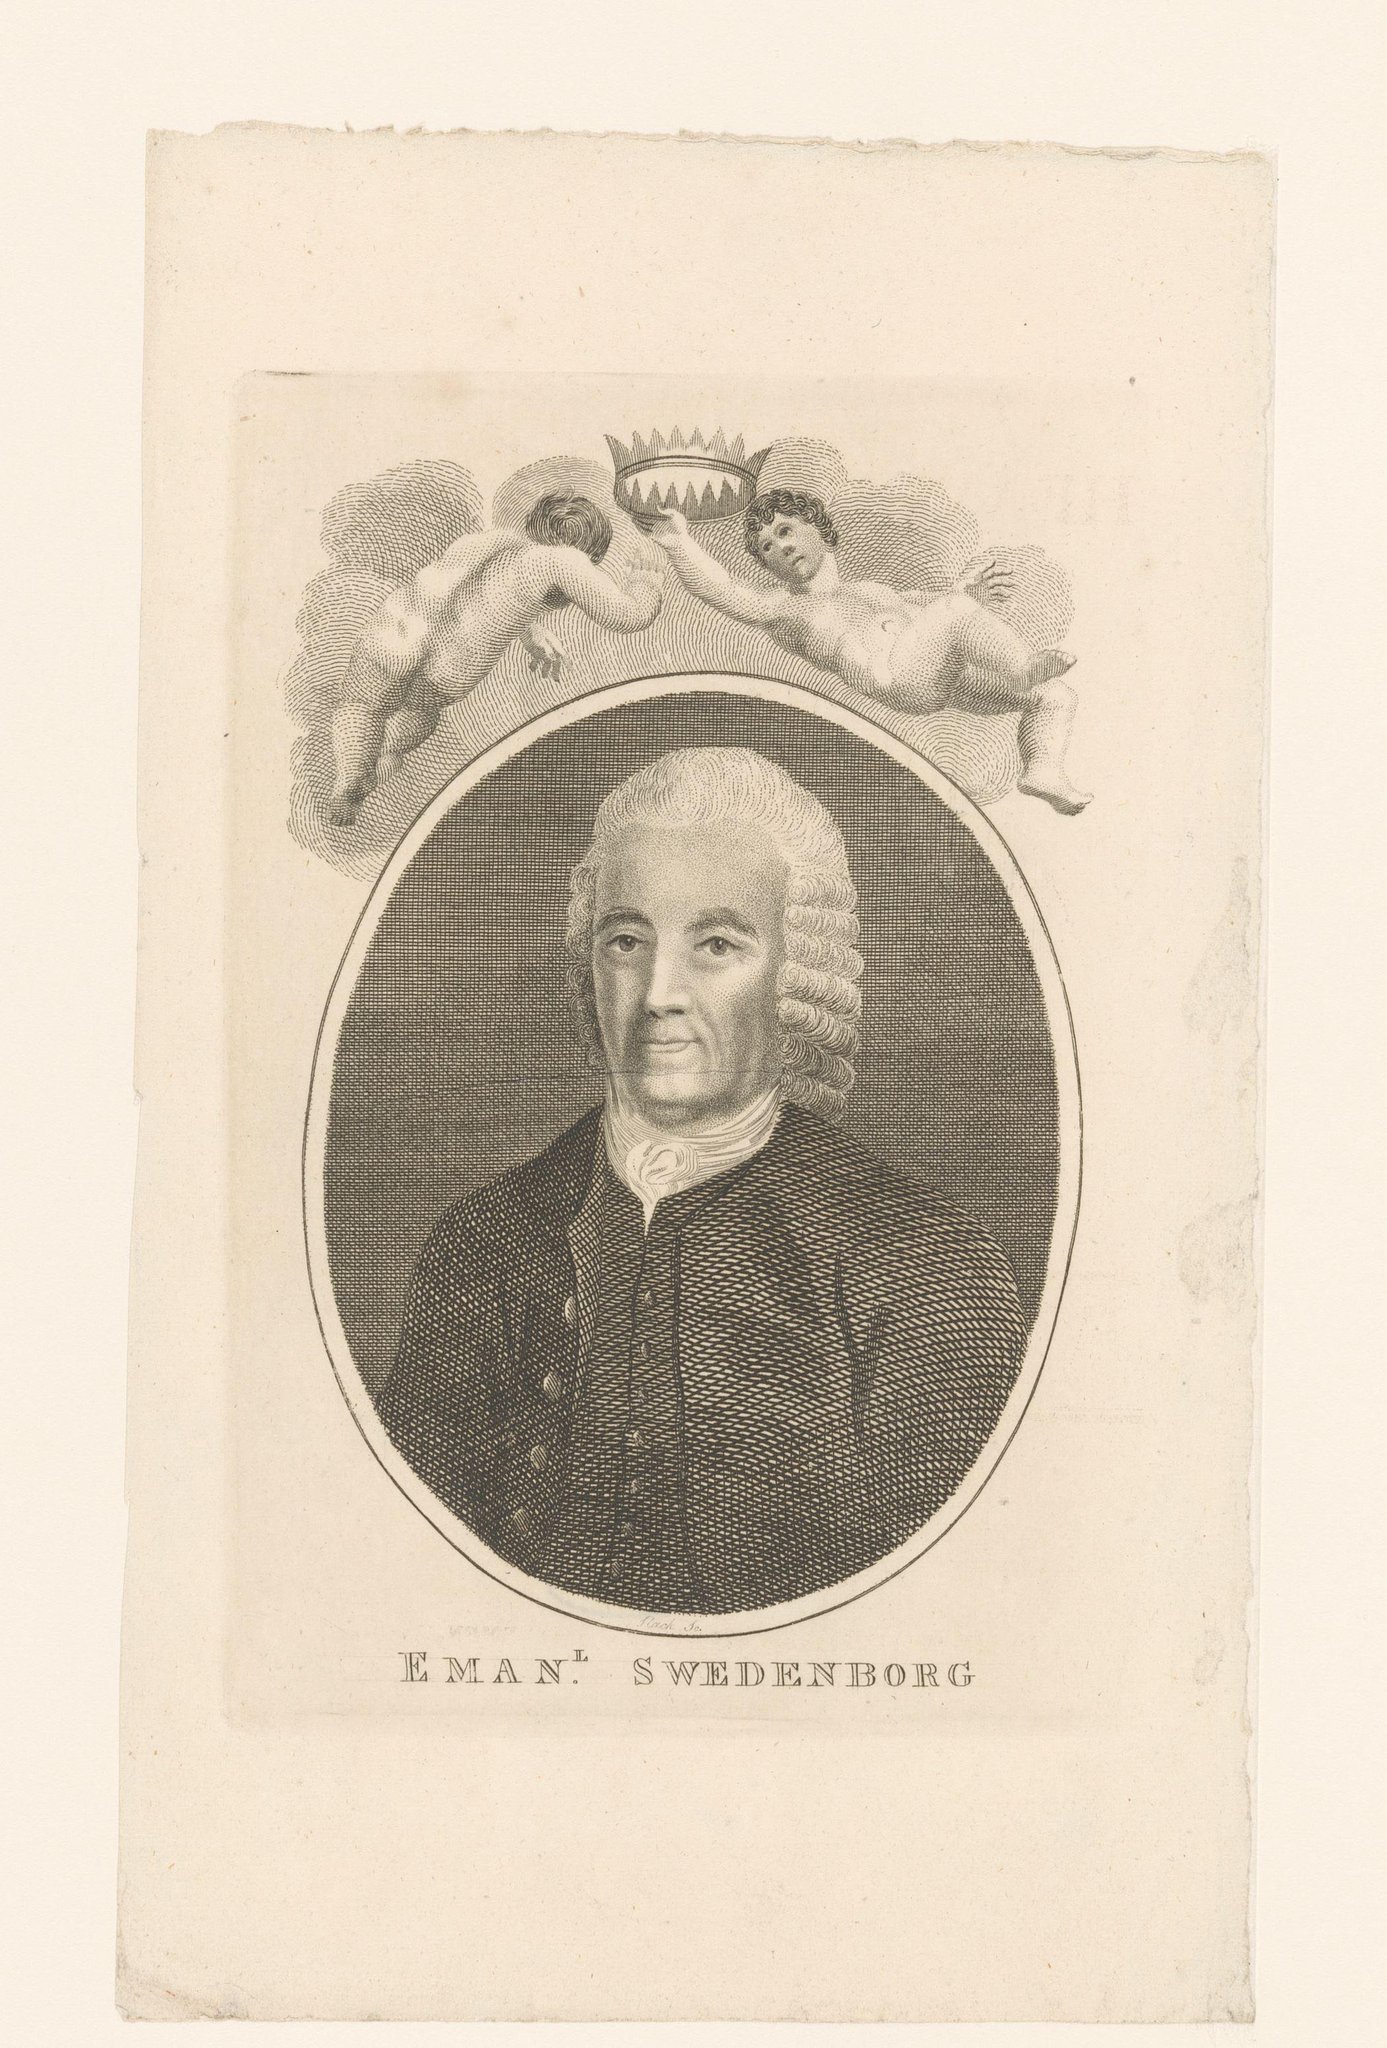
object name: print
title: Portret van Emanuel Swedenborg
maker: hack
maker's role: print maker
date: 1730-1799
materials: paper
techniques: engraving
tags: historical persons, scholar, philosopher (+ portrait of scholar, scientist)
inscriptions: collector's mark: Lugt 2228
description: Portret van Emanuel Swedenborg, Zweedse wetenschapper. Buste in ovaal, boven het portret twee putti met kroon.